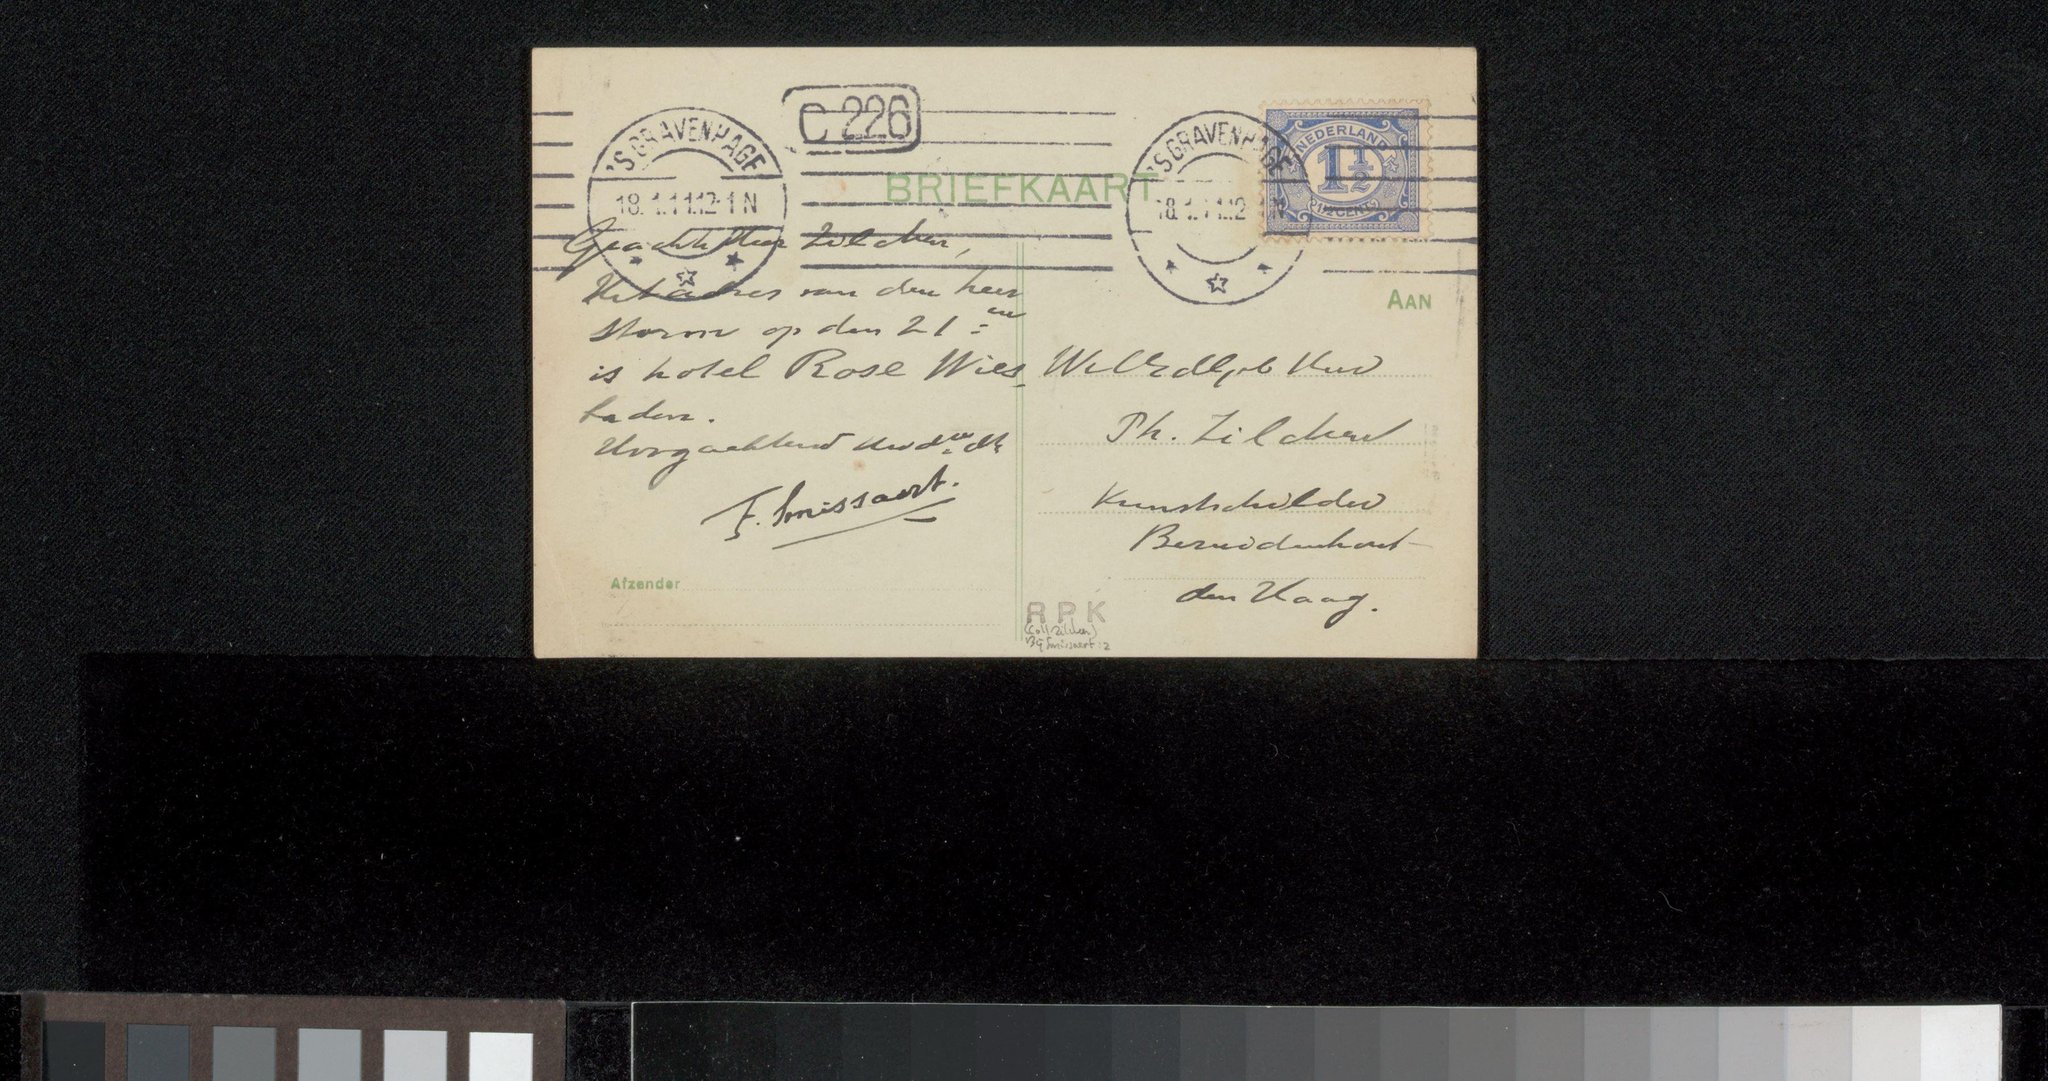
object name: postcard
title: Briefkaart aan Philip Zilcken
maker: frans smissaert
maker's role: draughtsman, print maker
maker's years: 1862-1944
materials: cardboard, ink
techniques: pen, writing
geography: the hague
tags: carel nicolaas storm van 's-gravesande, painter, draughtsman, philip zilcken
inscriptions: collector's mark: ‘RPK’